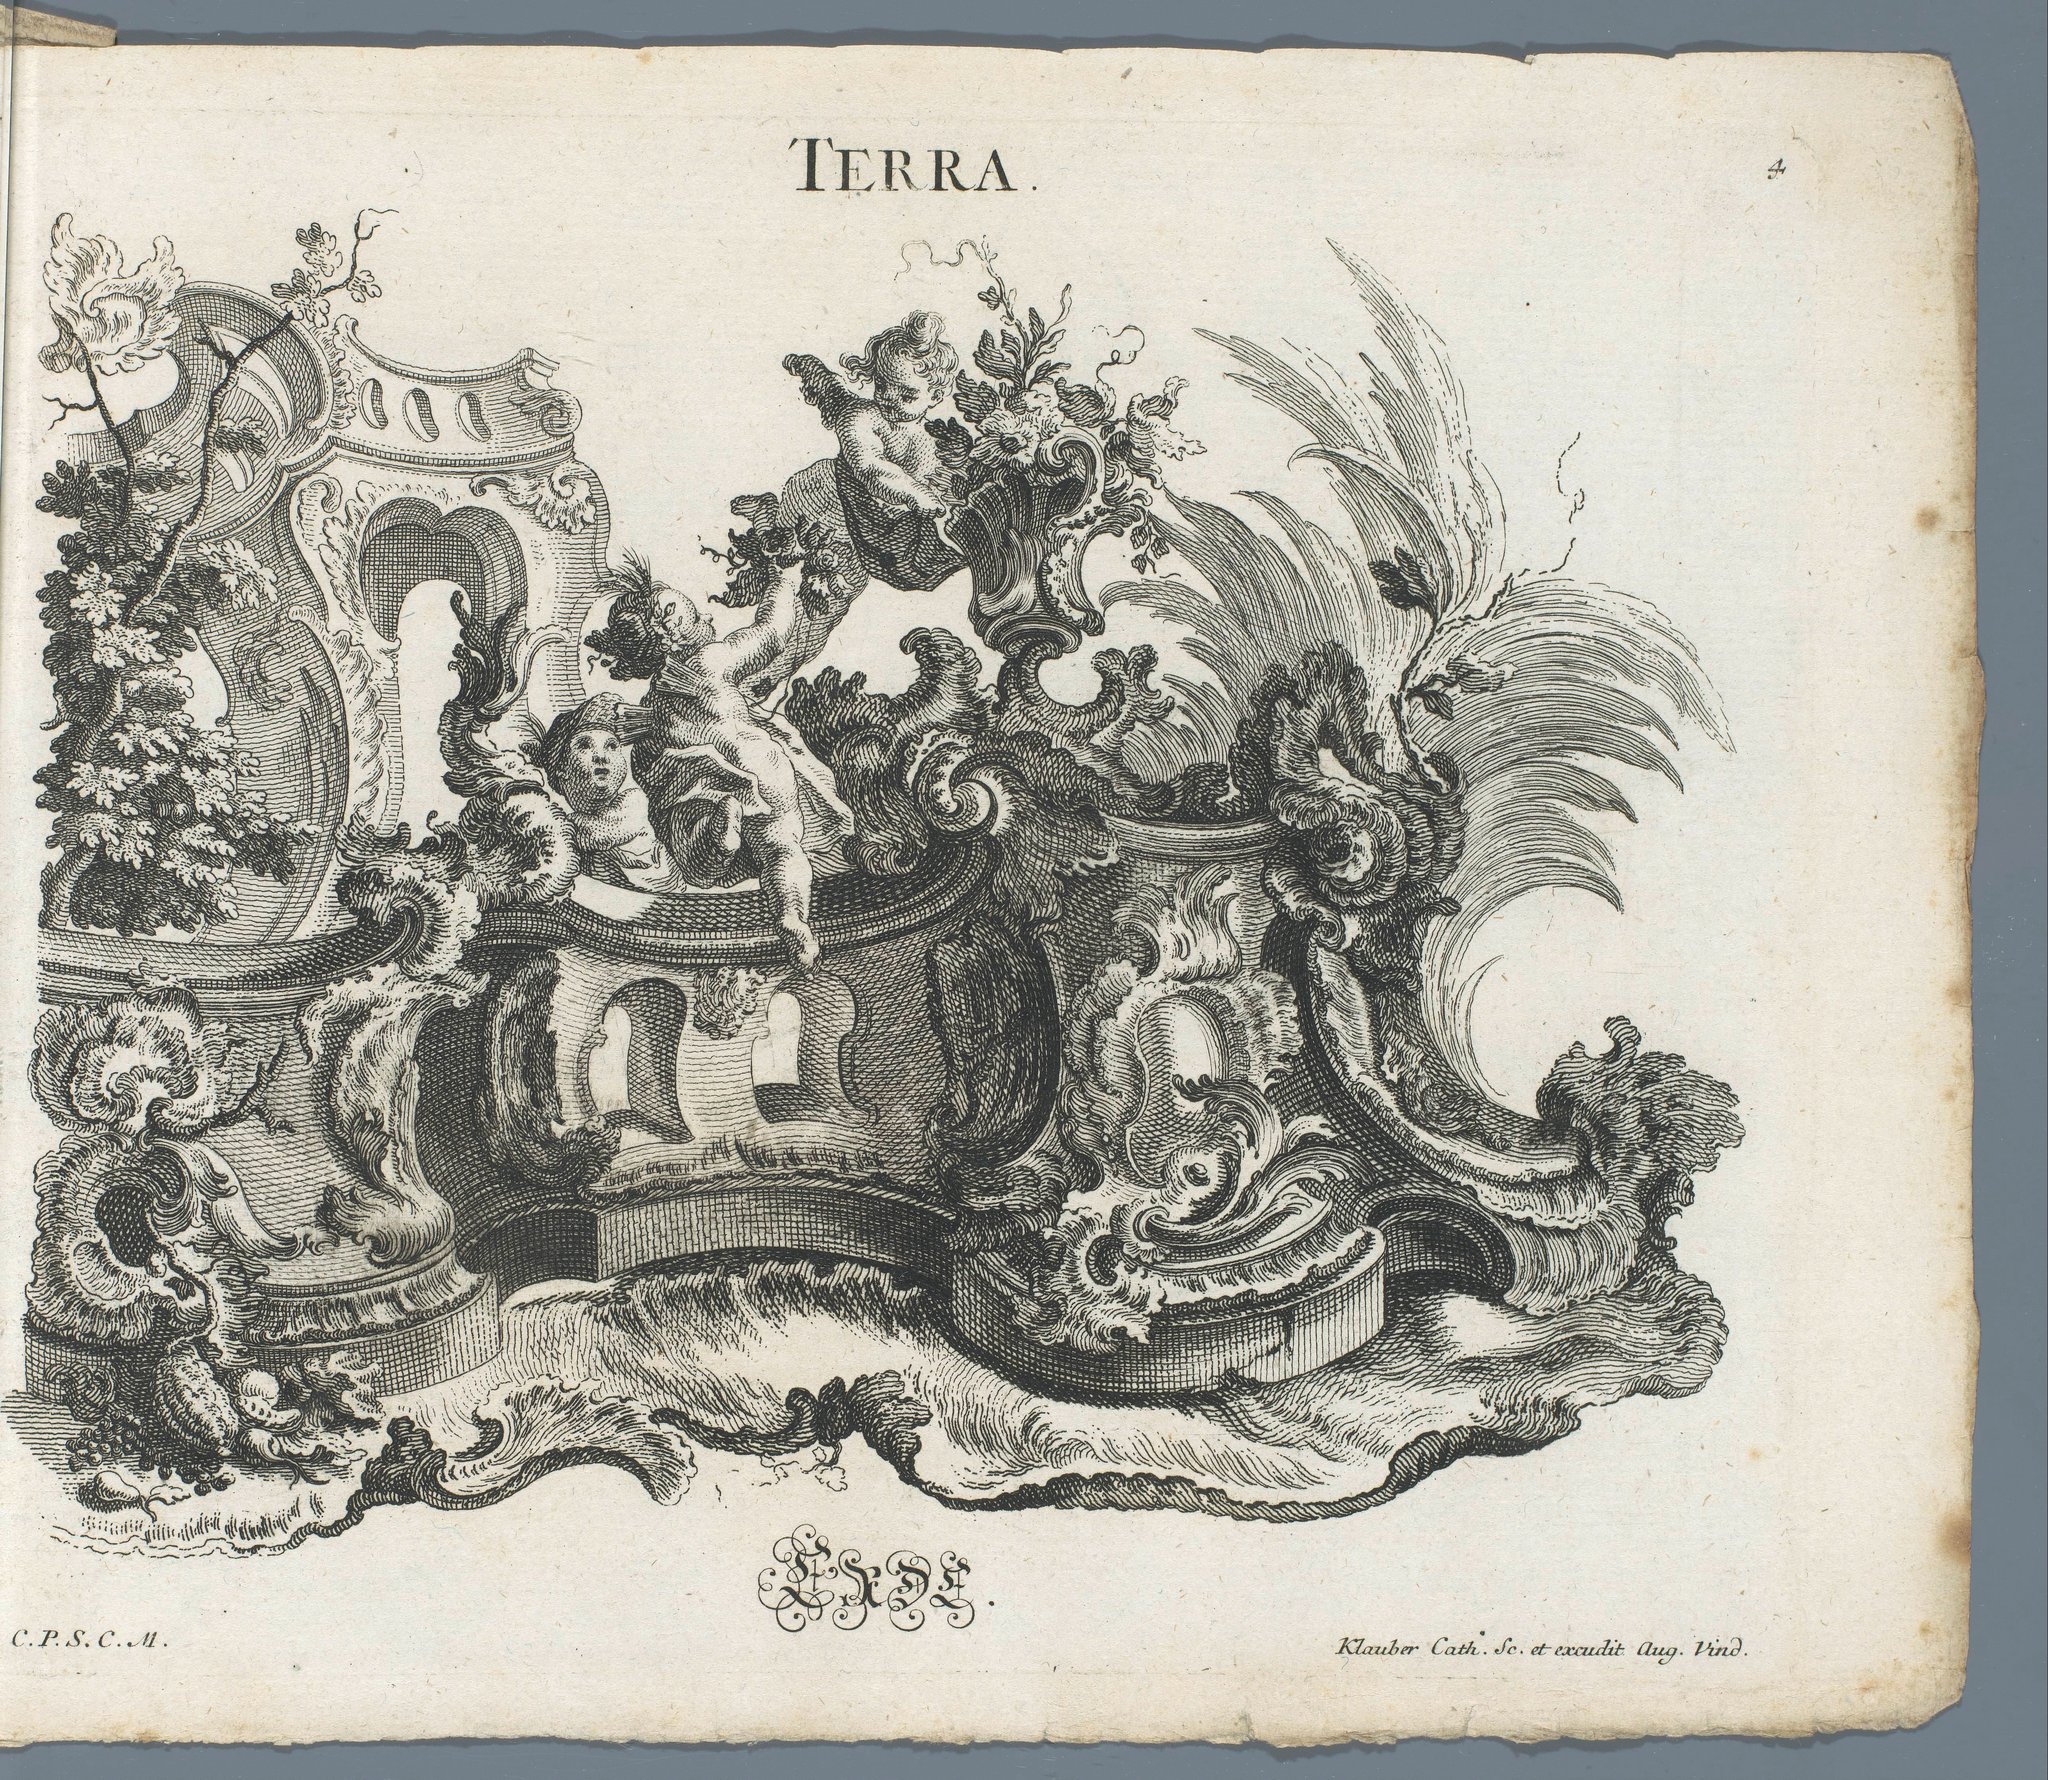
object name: ornament print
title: De vier elementen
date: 1750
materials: paper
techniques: etching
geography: augsburg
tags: 'terra', 'carro della terra' (ripa), cupids: 'amores', 'amoretti', 'putti'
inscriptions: collector's mark: Lugt 2228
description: Personificatie van het element aarde. Rocaille ornament in landschap met drie putti met bloemen en vaas met bloemen. Uitgeversnummer g.